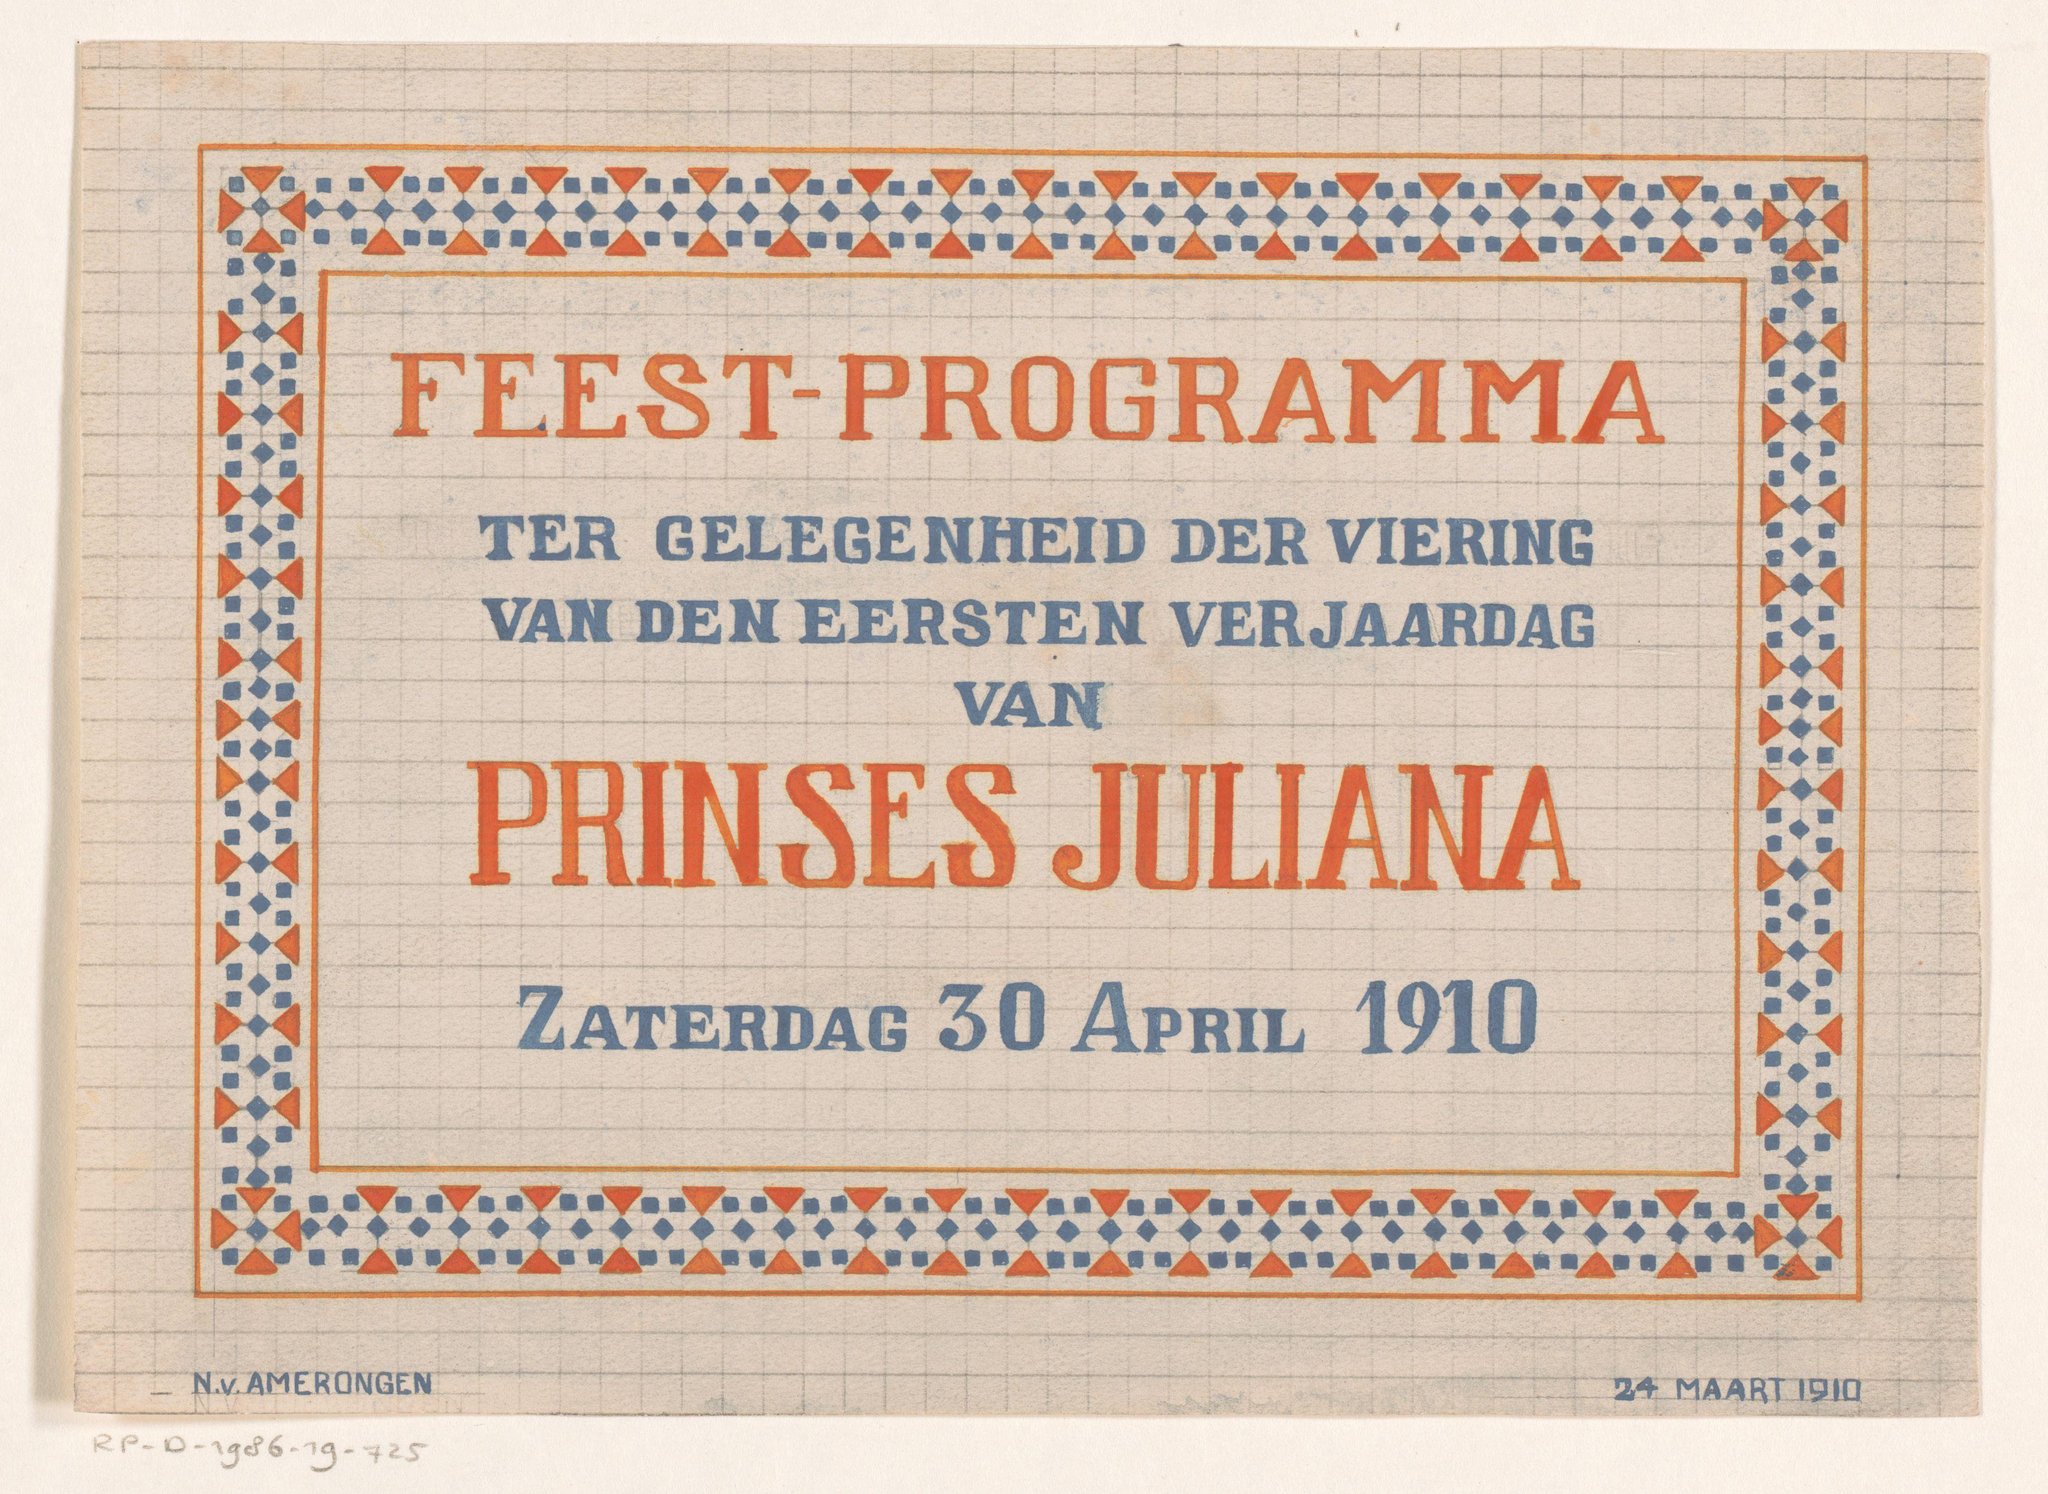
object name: drawing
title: Ontwerp voor een feestprogramma ter gelegenheid van de eerste verjaardag van prinses Juliana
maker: reinier willem petrus de vries (1874-1953)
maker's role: draughtsman, print maker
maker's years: 1874-1953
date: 1910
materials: paint, pencil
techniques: brush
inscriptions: collector's mark: ‘R:MVS.’, name: ‘N. v. AMERONGEN’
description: Ontwerp met tekst in een decoratief kader met patroon van driehoeken en vierkanten.